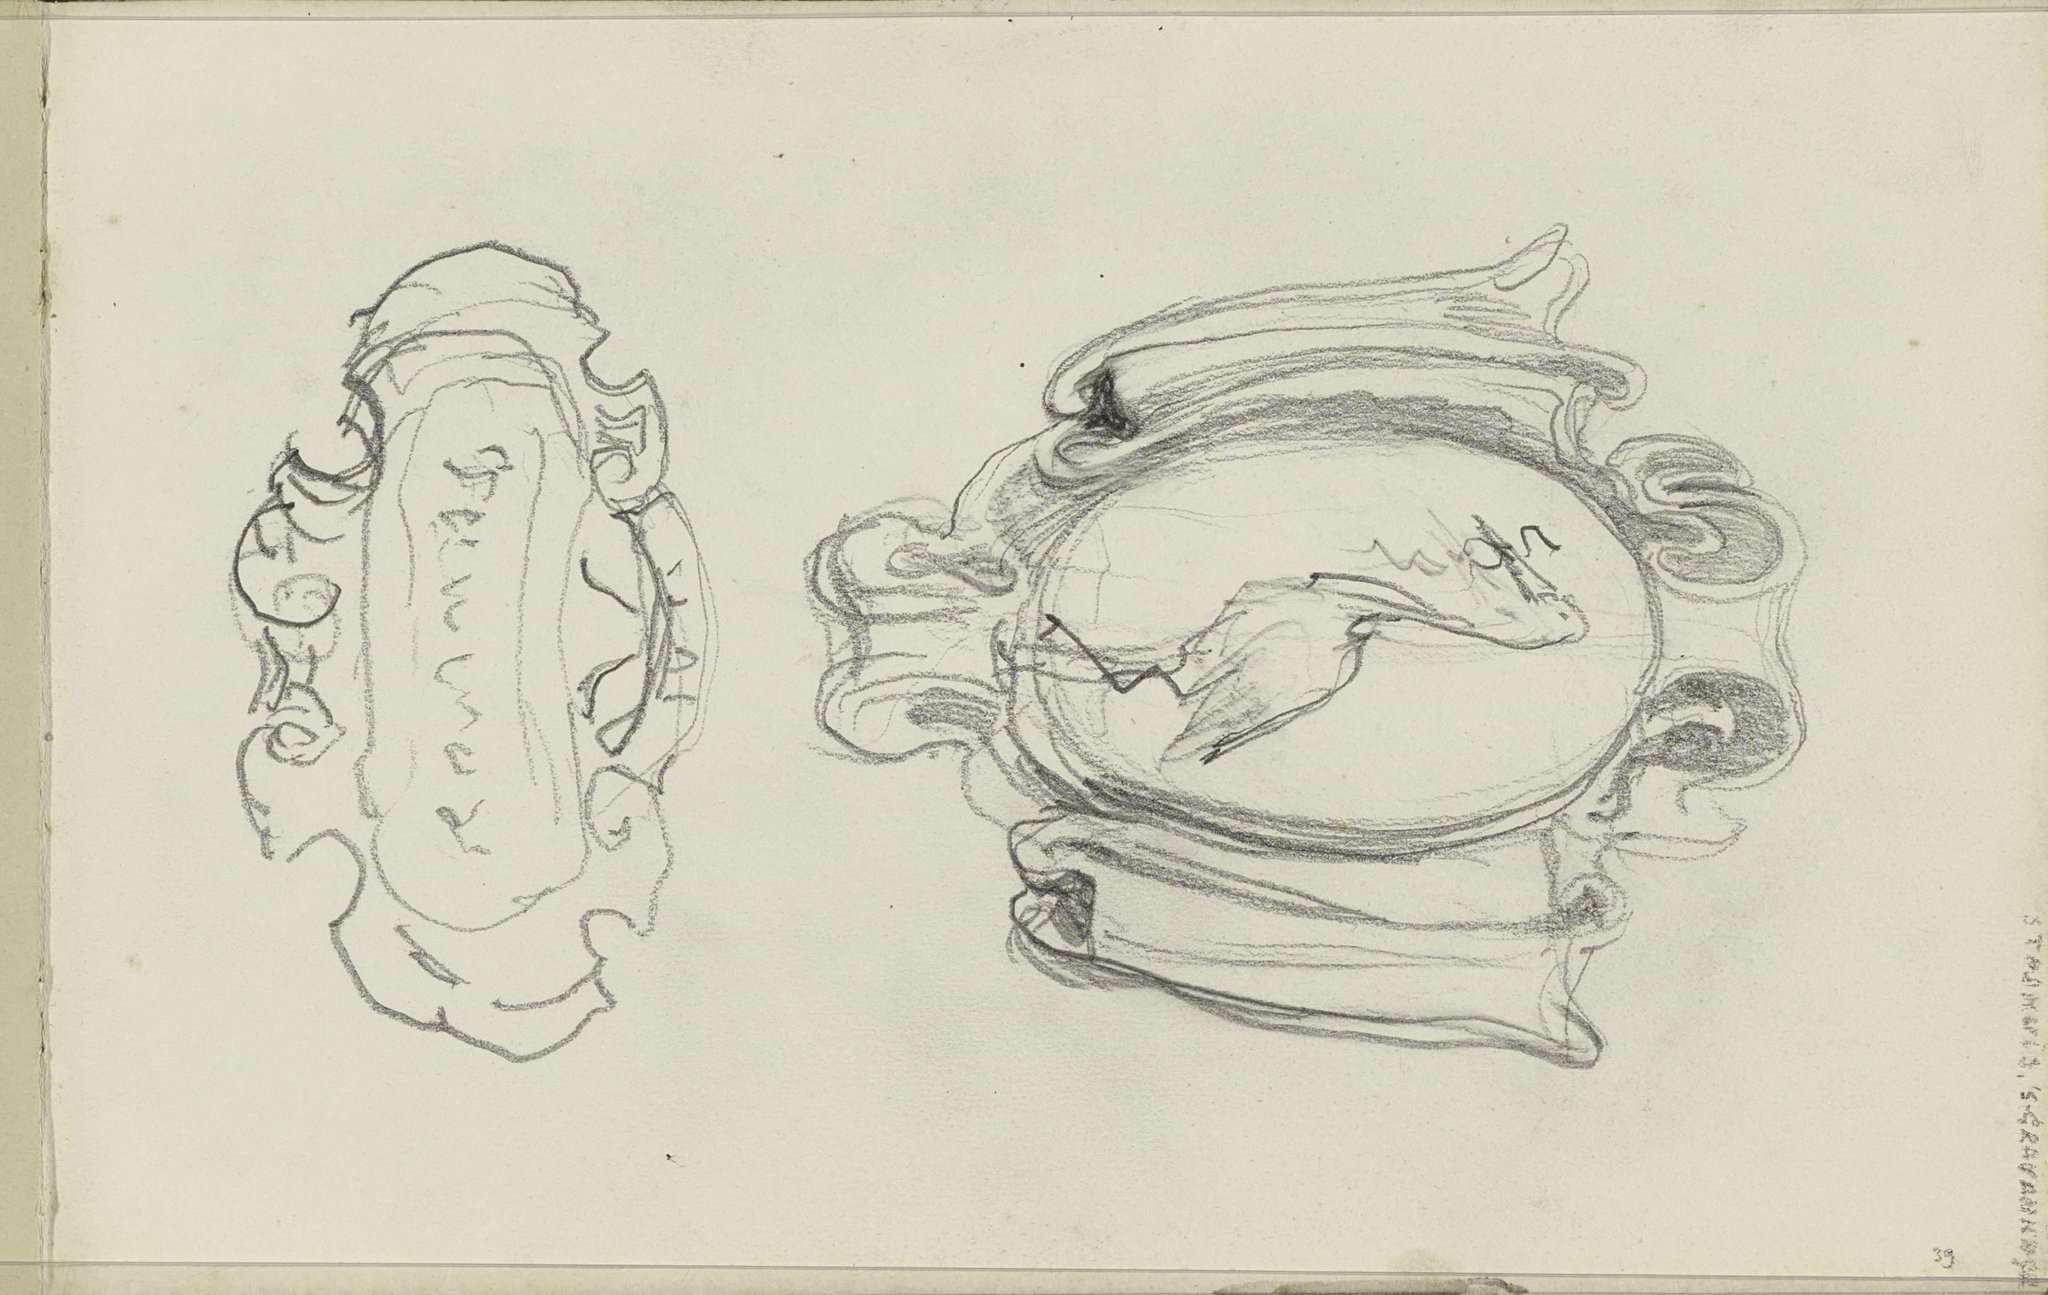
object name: sketchbook leaf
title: Stadswapens van het stadhuis van Den Haag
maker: johannes bosboom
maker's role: draughtsman, painter, print maker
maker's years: 1817-1891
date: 1873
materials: paper, pencil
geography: the hague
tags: coat of arms (as symbol of the state, etc.) (+ city; municipal)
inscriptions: annotation: ‘DEN HAGE’, annotation: ‘STADHUIS, 'S-GRAVENHAGE’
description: Het wapen van Den Haag stelt een staande ooievaar voor. Tevens een studie van een gedecoreerd wapen met de plaatsnaam. Blad 39 recto uit een schetsboek met 39 bladen.